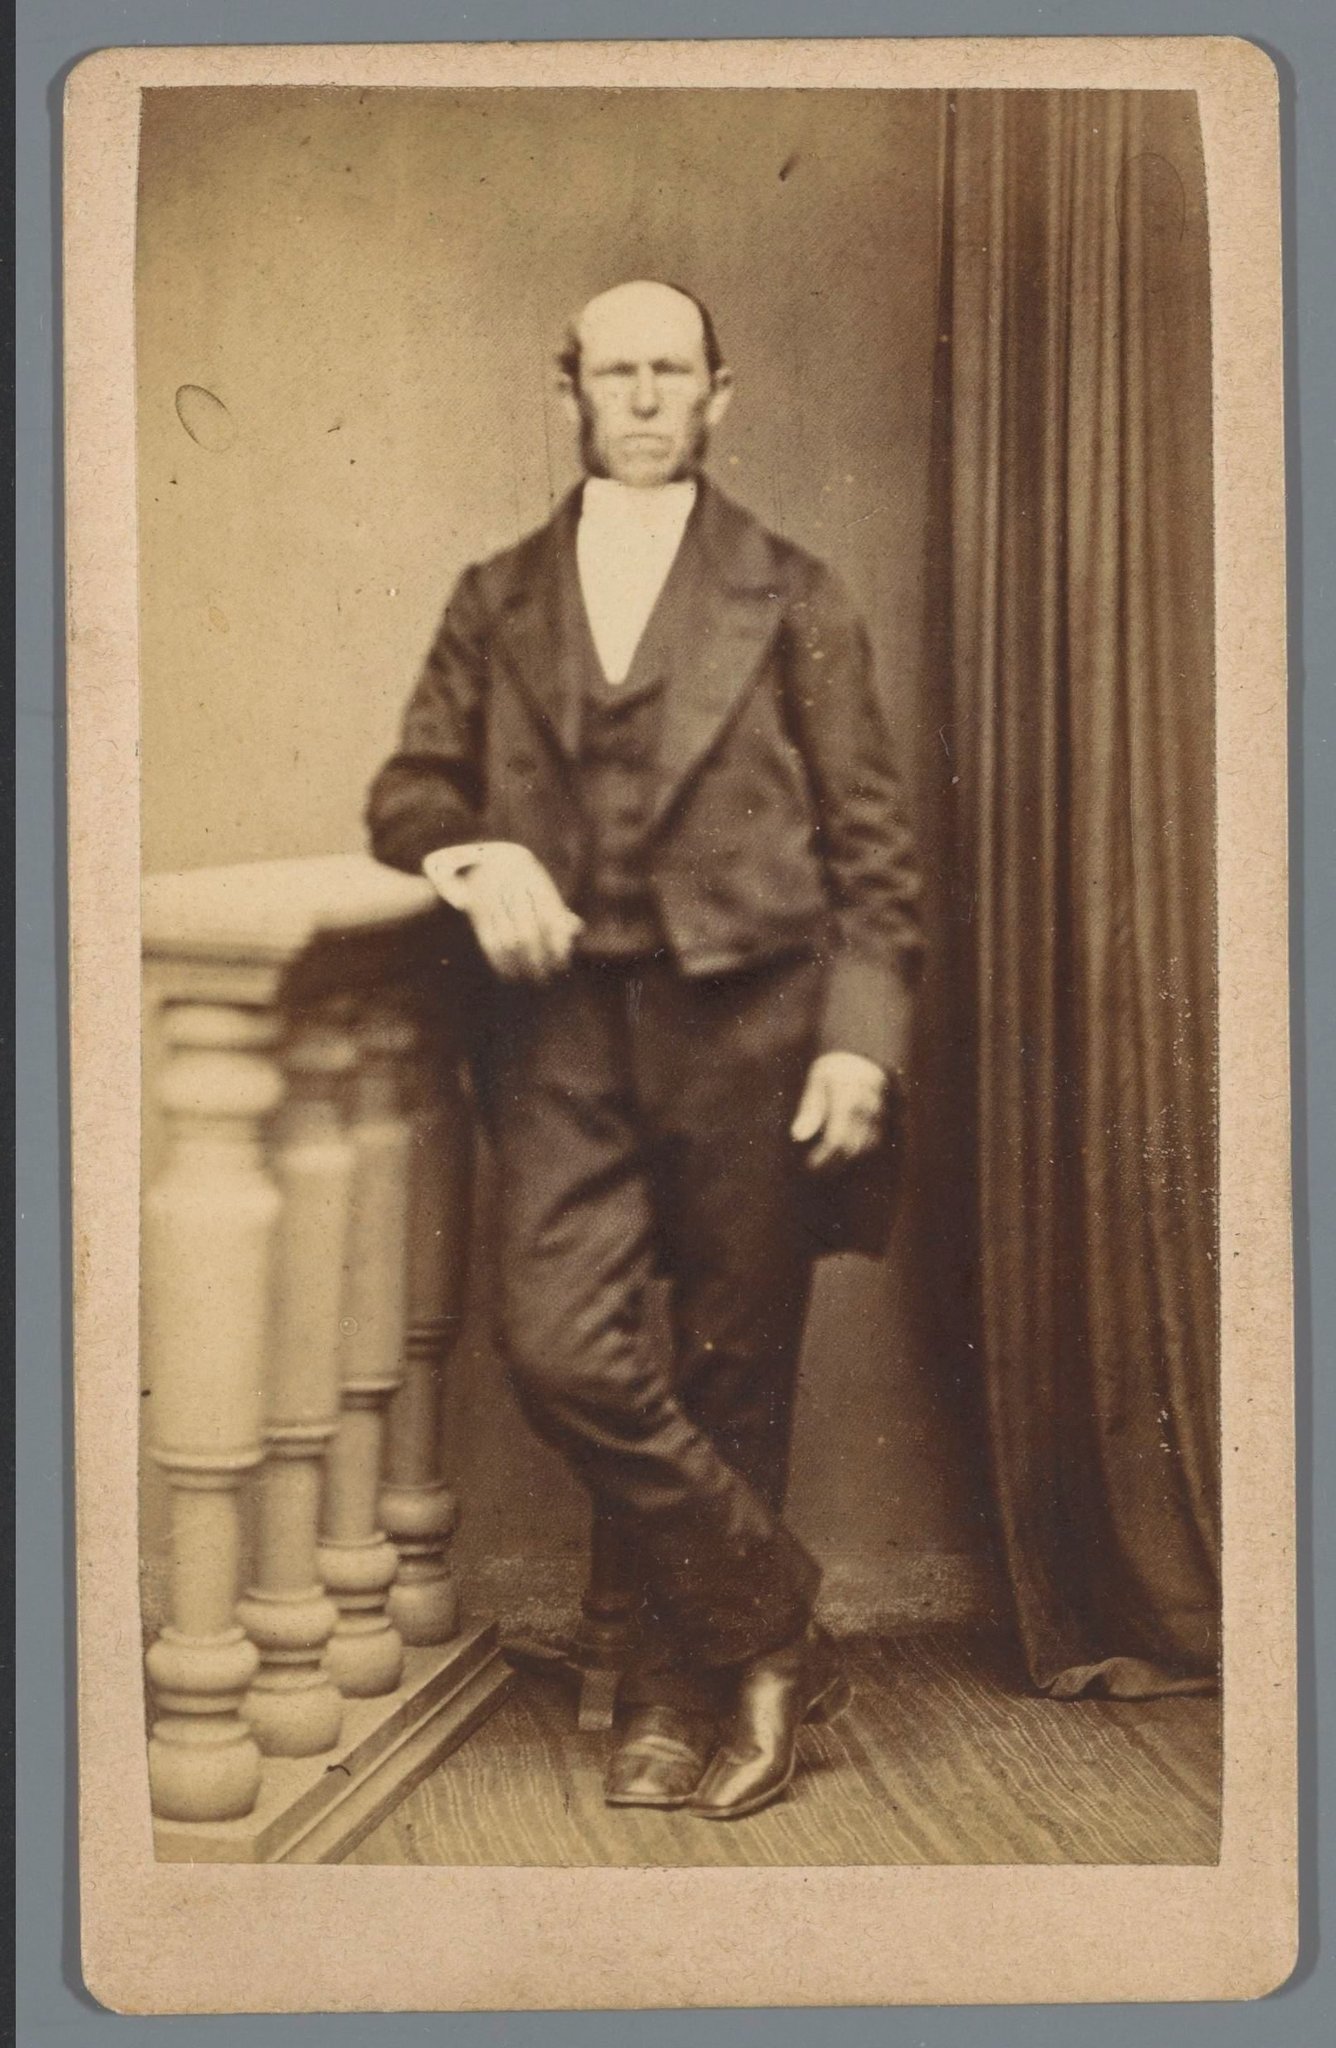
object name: photograph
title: Portret van een onbekende staande man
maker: bernardus petrus rabels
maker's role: fotograaf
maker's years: 1824-1906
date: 1870-1893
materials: cardboard, paper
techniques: albumen print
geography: amsterdam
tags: adult man, anonymous historical person portrayed, amsterdam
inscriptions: inscription: ‘Photographisch Atelier/ van/ B.P. Rabels/ Prinsengracht bij de Leliestraat M.M.138./ Amsterdam.’